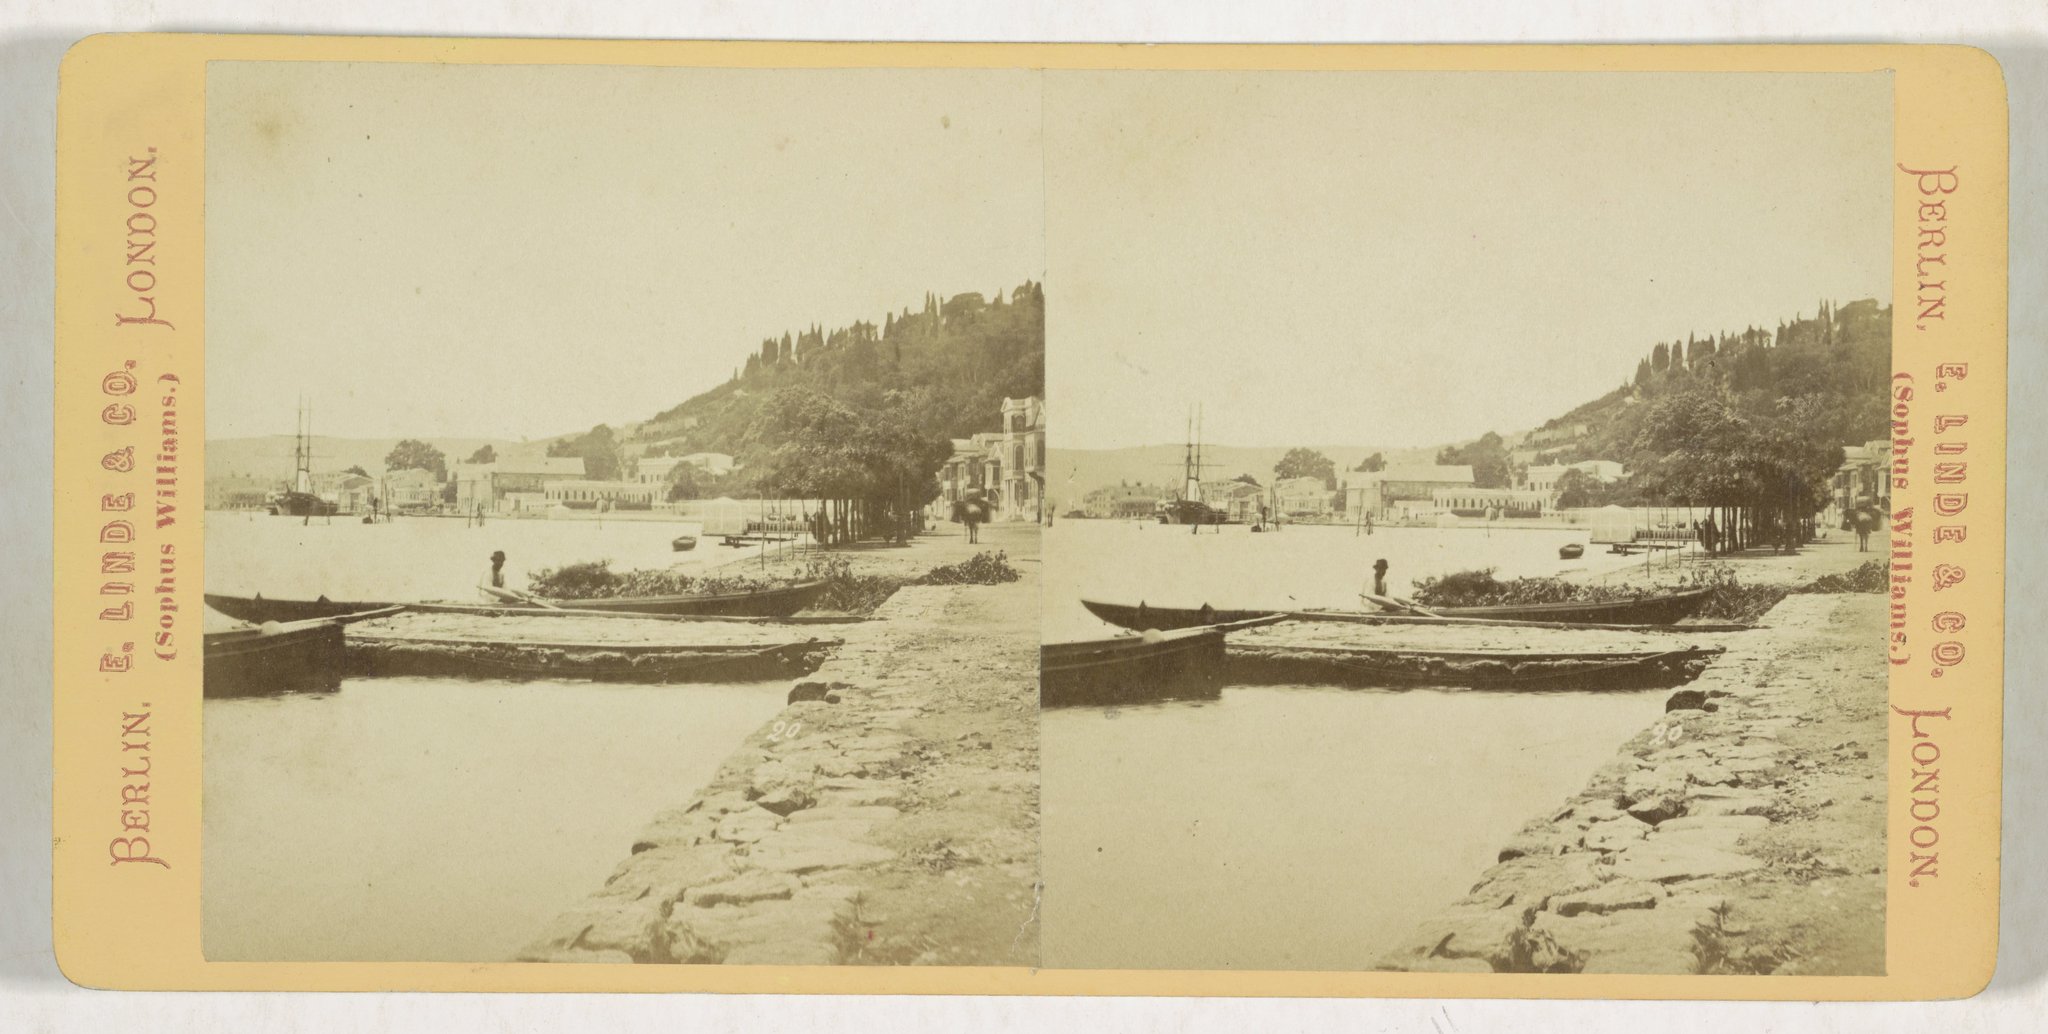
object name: stereograph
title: Constantinopel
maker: Anonymous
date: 1873-1890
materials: cardboard, paper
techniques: albumen print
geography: berlin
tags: harbour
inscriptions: number: ‘20’